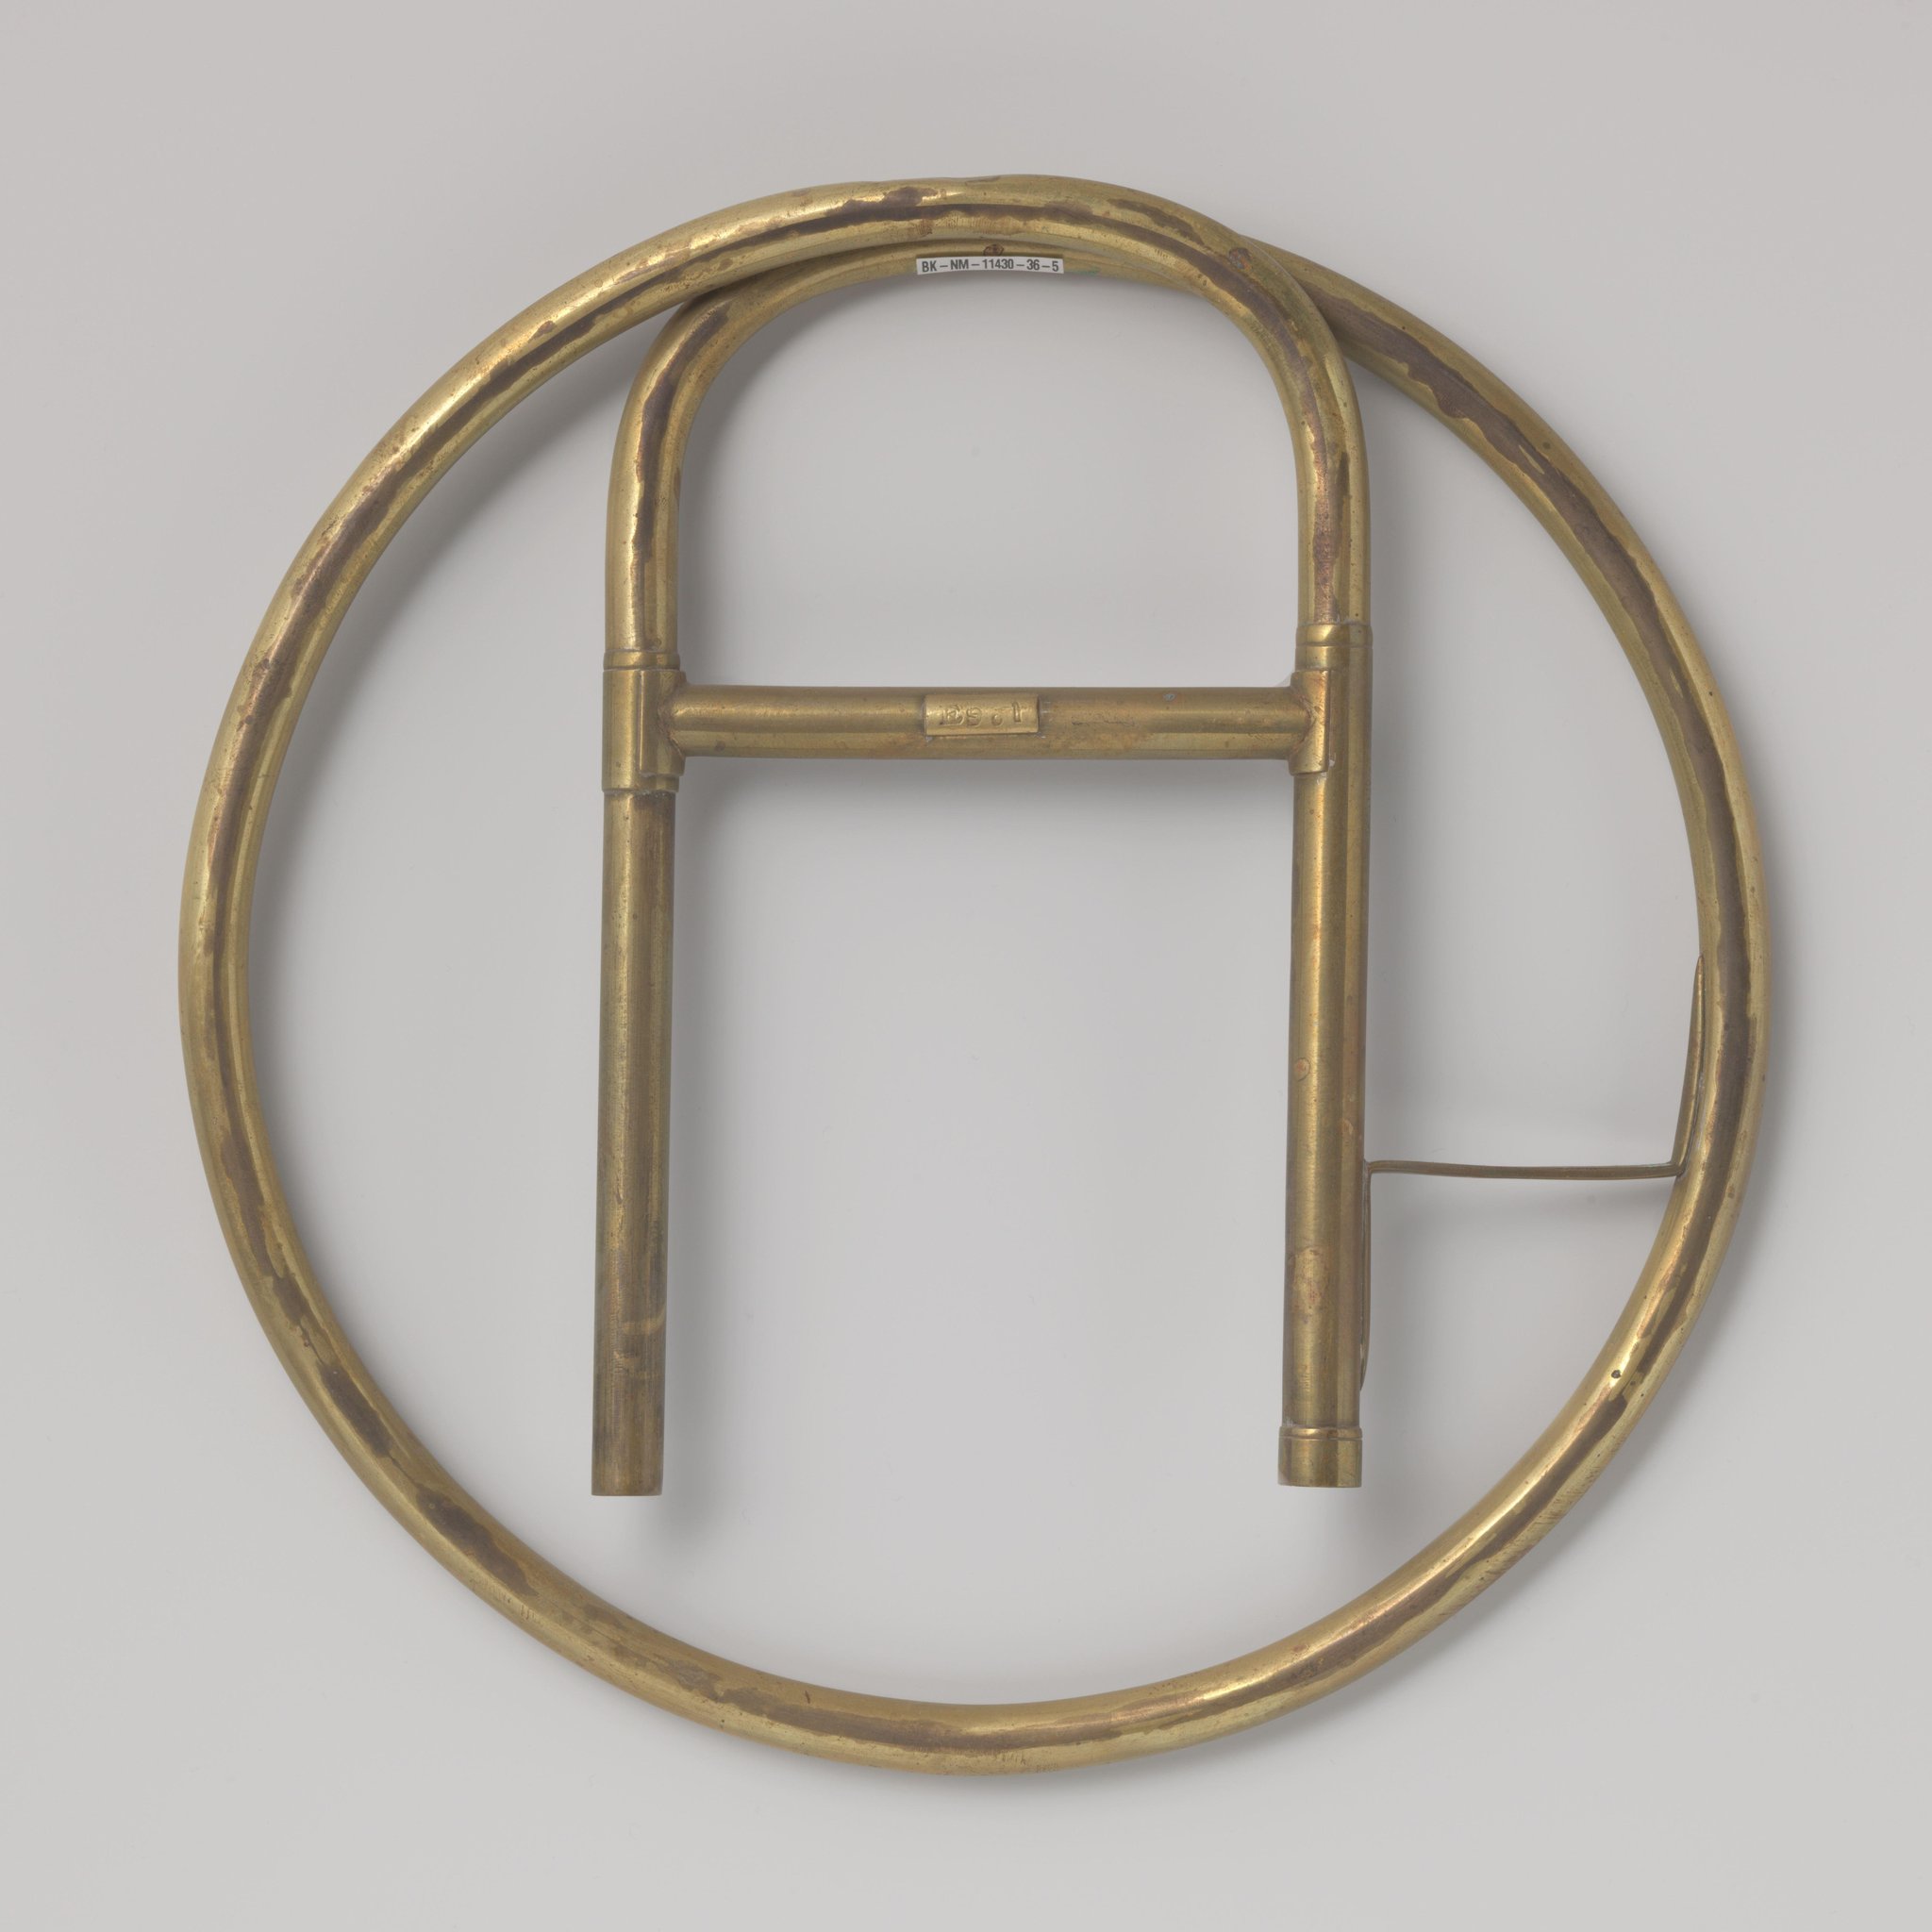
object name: horn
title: Invention horn crook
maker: carl gottlob schüster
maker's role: instrument maker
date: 1850-1950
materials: copper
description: Beugel van inventionshoorn. Gemerkt: Es.1